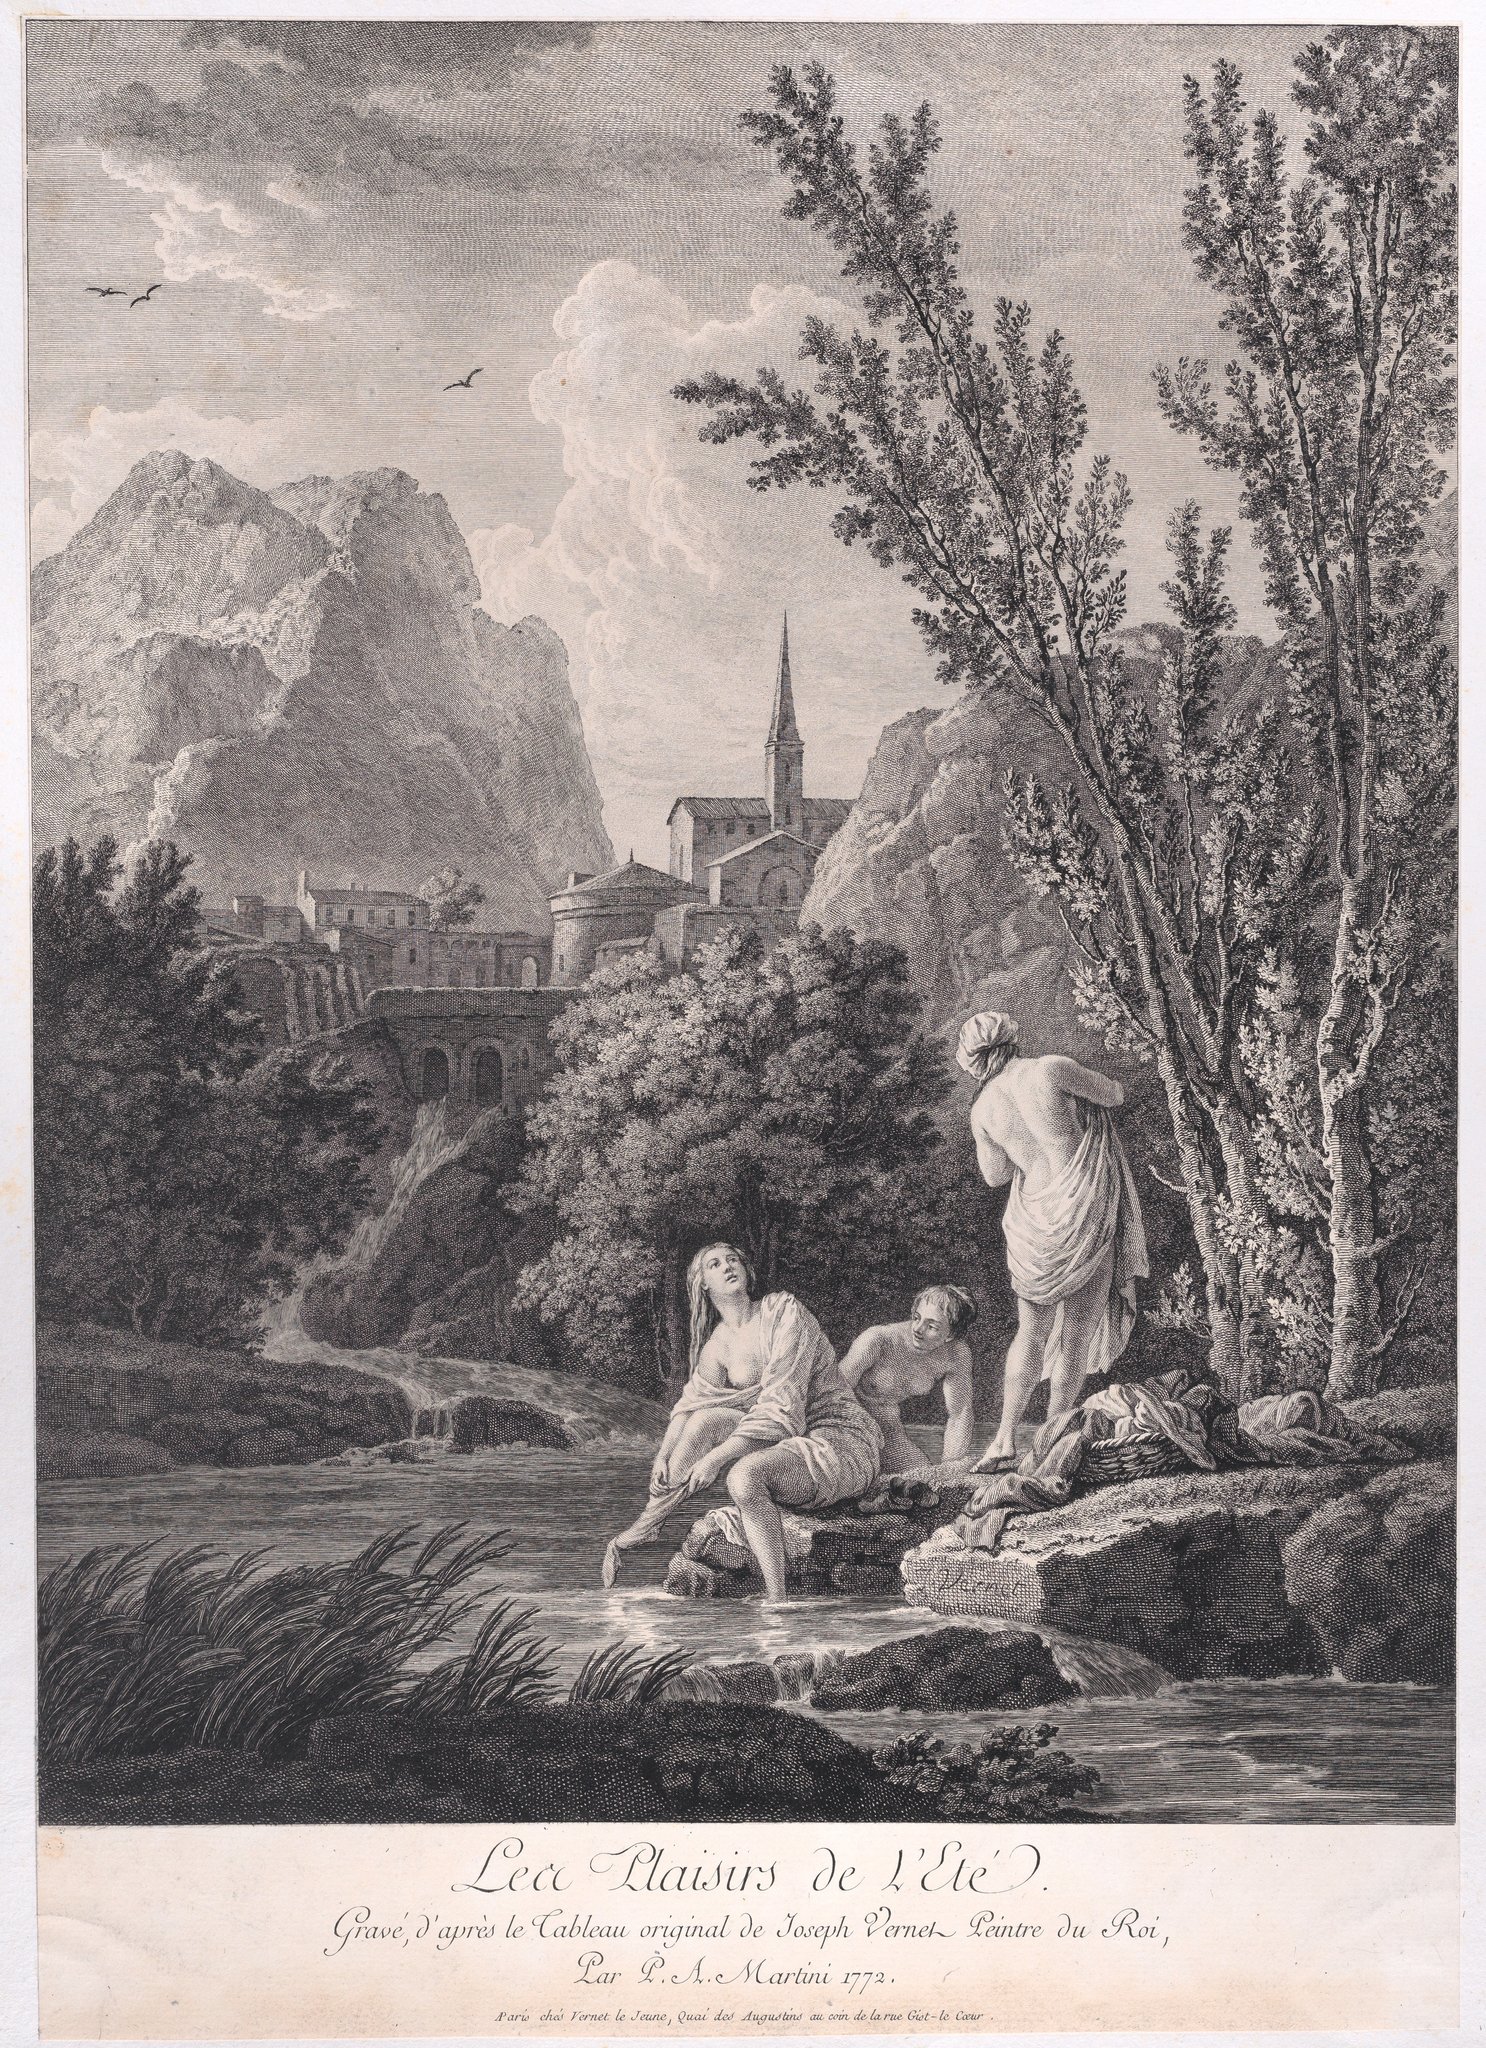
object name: print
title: The Delights of Summer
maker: joseph vernet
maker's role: artist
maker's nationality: french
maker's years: 1714-1789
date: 1772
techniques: engraving